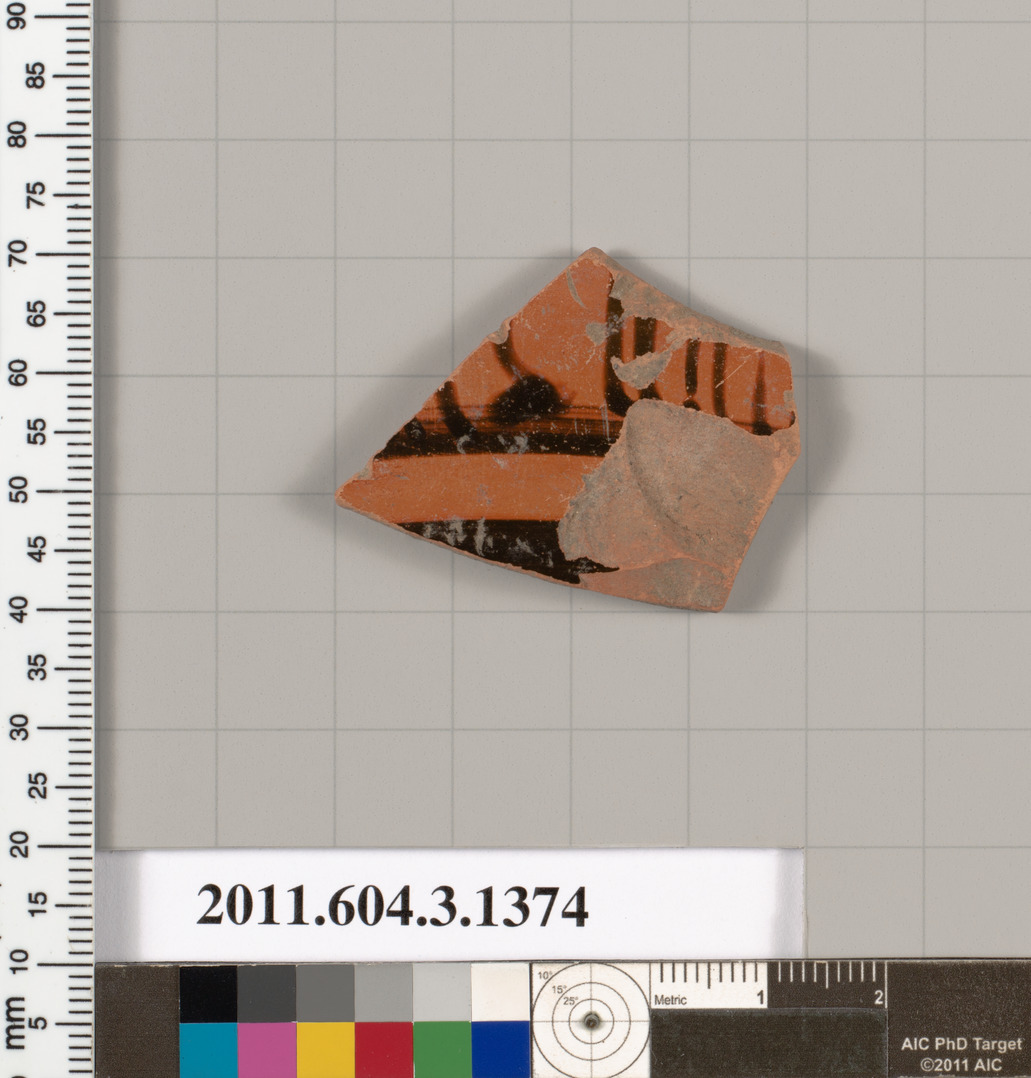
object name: skyphos fragment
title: Terracotta fragment of a skyphos (deep drinking cup)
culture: greek, attic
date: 500-468 BCE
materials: terracotta